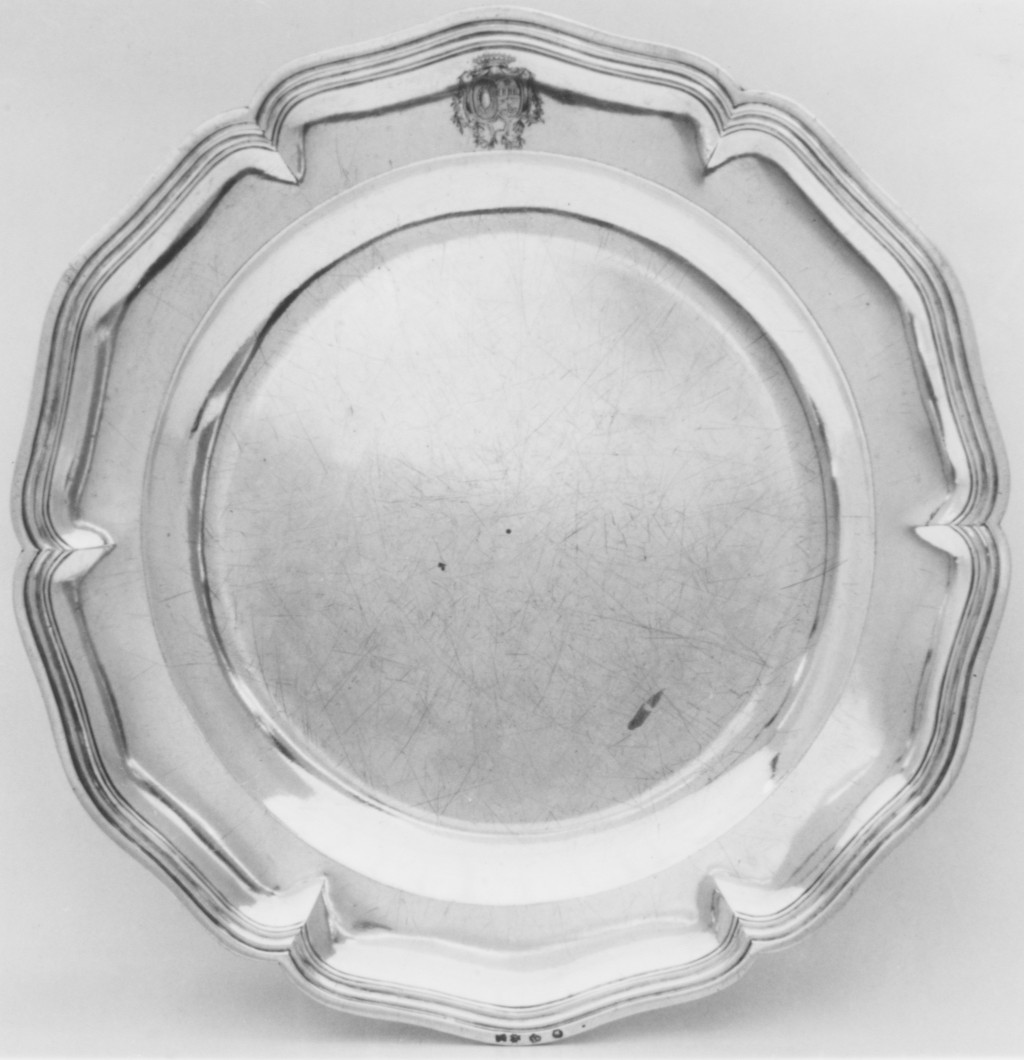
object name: plate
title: Plate with the arms of Jean-Euverte Miron de la Mothe (1757–1835) and his wife, Angélique Crignon de Bonvalet (1746-1839)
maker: alexis micalef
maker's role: maker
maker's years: 1726-1818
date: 1765-1766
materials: silver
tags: coat of arms